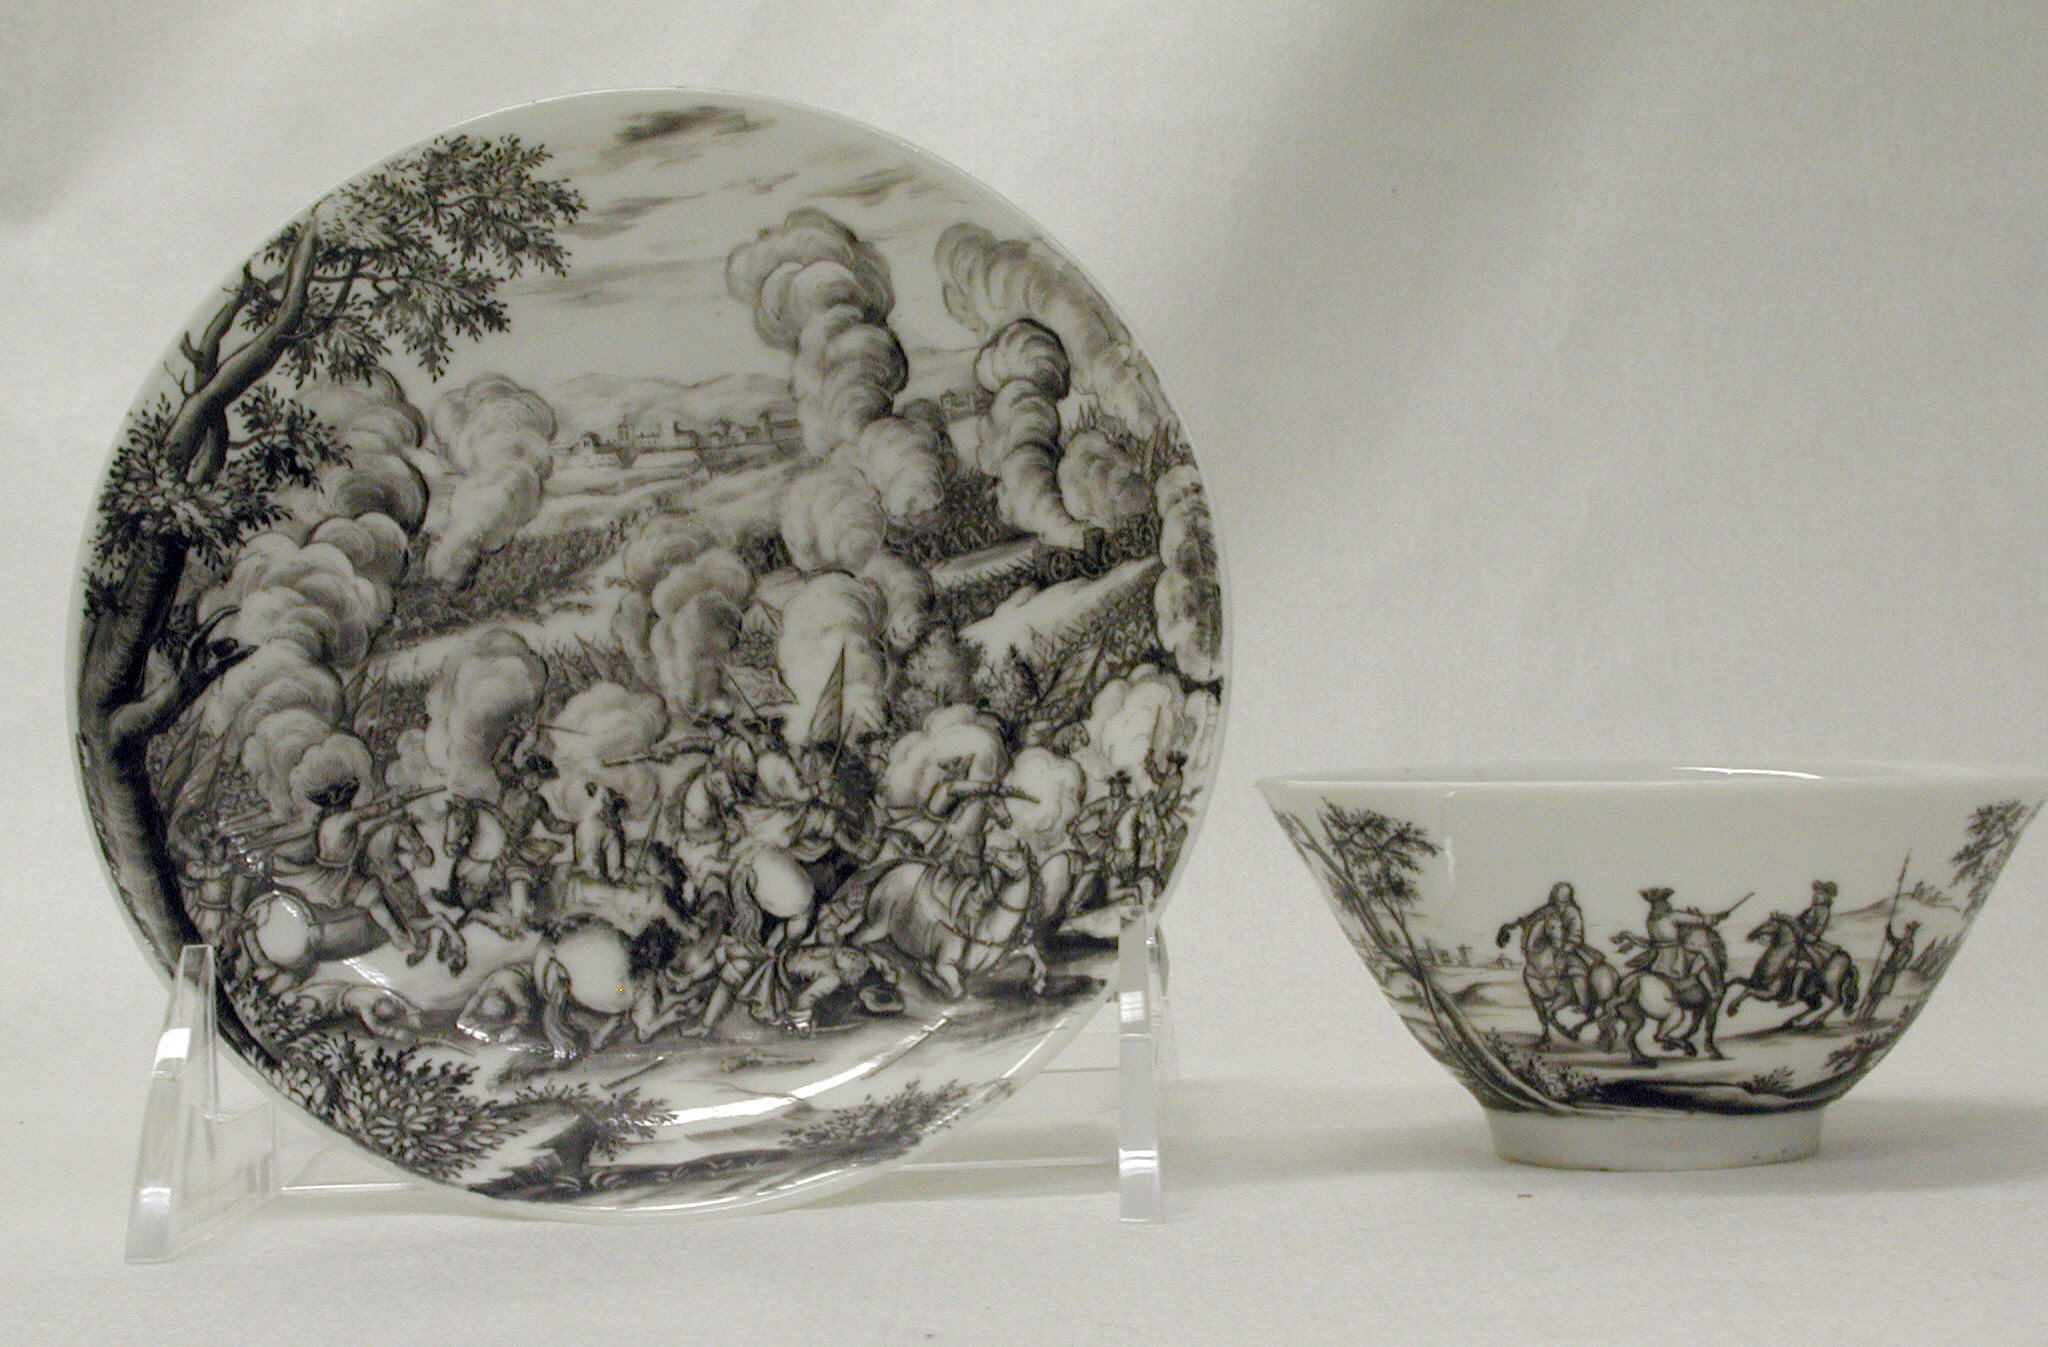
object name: teabowl and saucer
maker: meissen manufactory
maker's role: manufactory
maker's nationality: german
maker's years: 1710-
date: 1720-1725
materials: hard paste porcelain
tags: battles,soldiers,horses